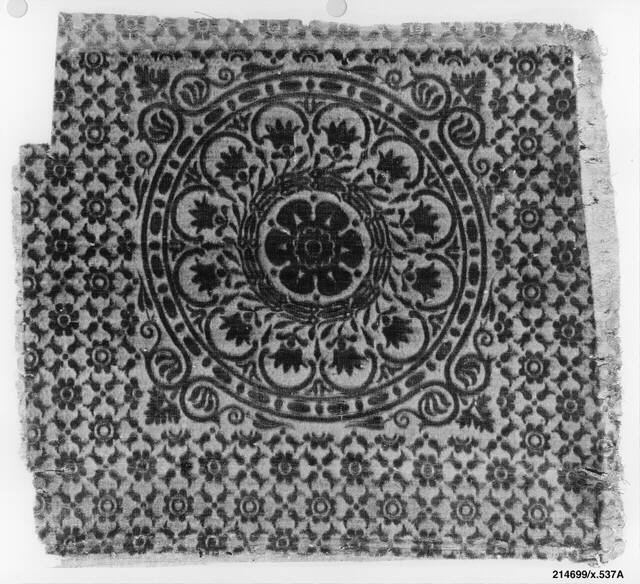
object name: piece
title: Irregular piece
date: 1801-1833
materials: wool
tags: flowers